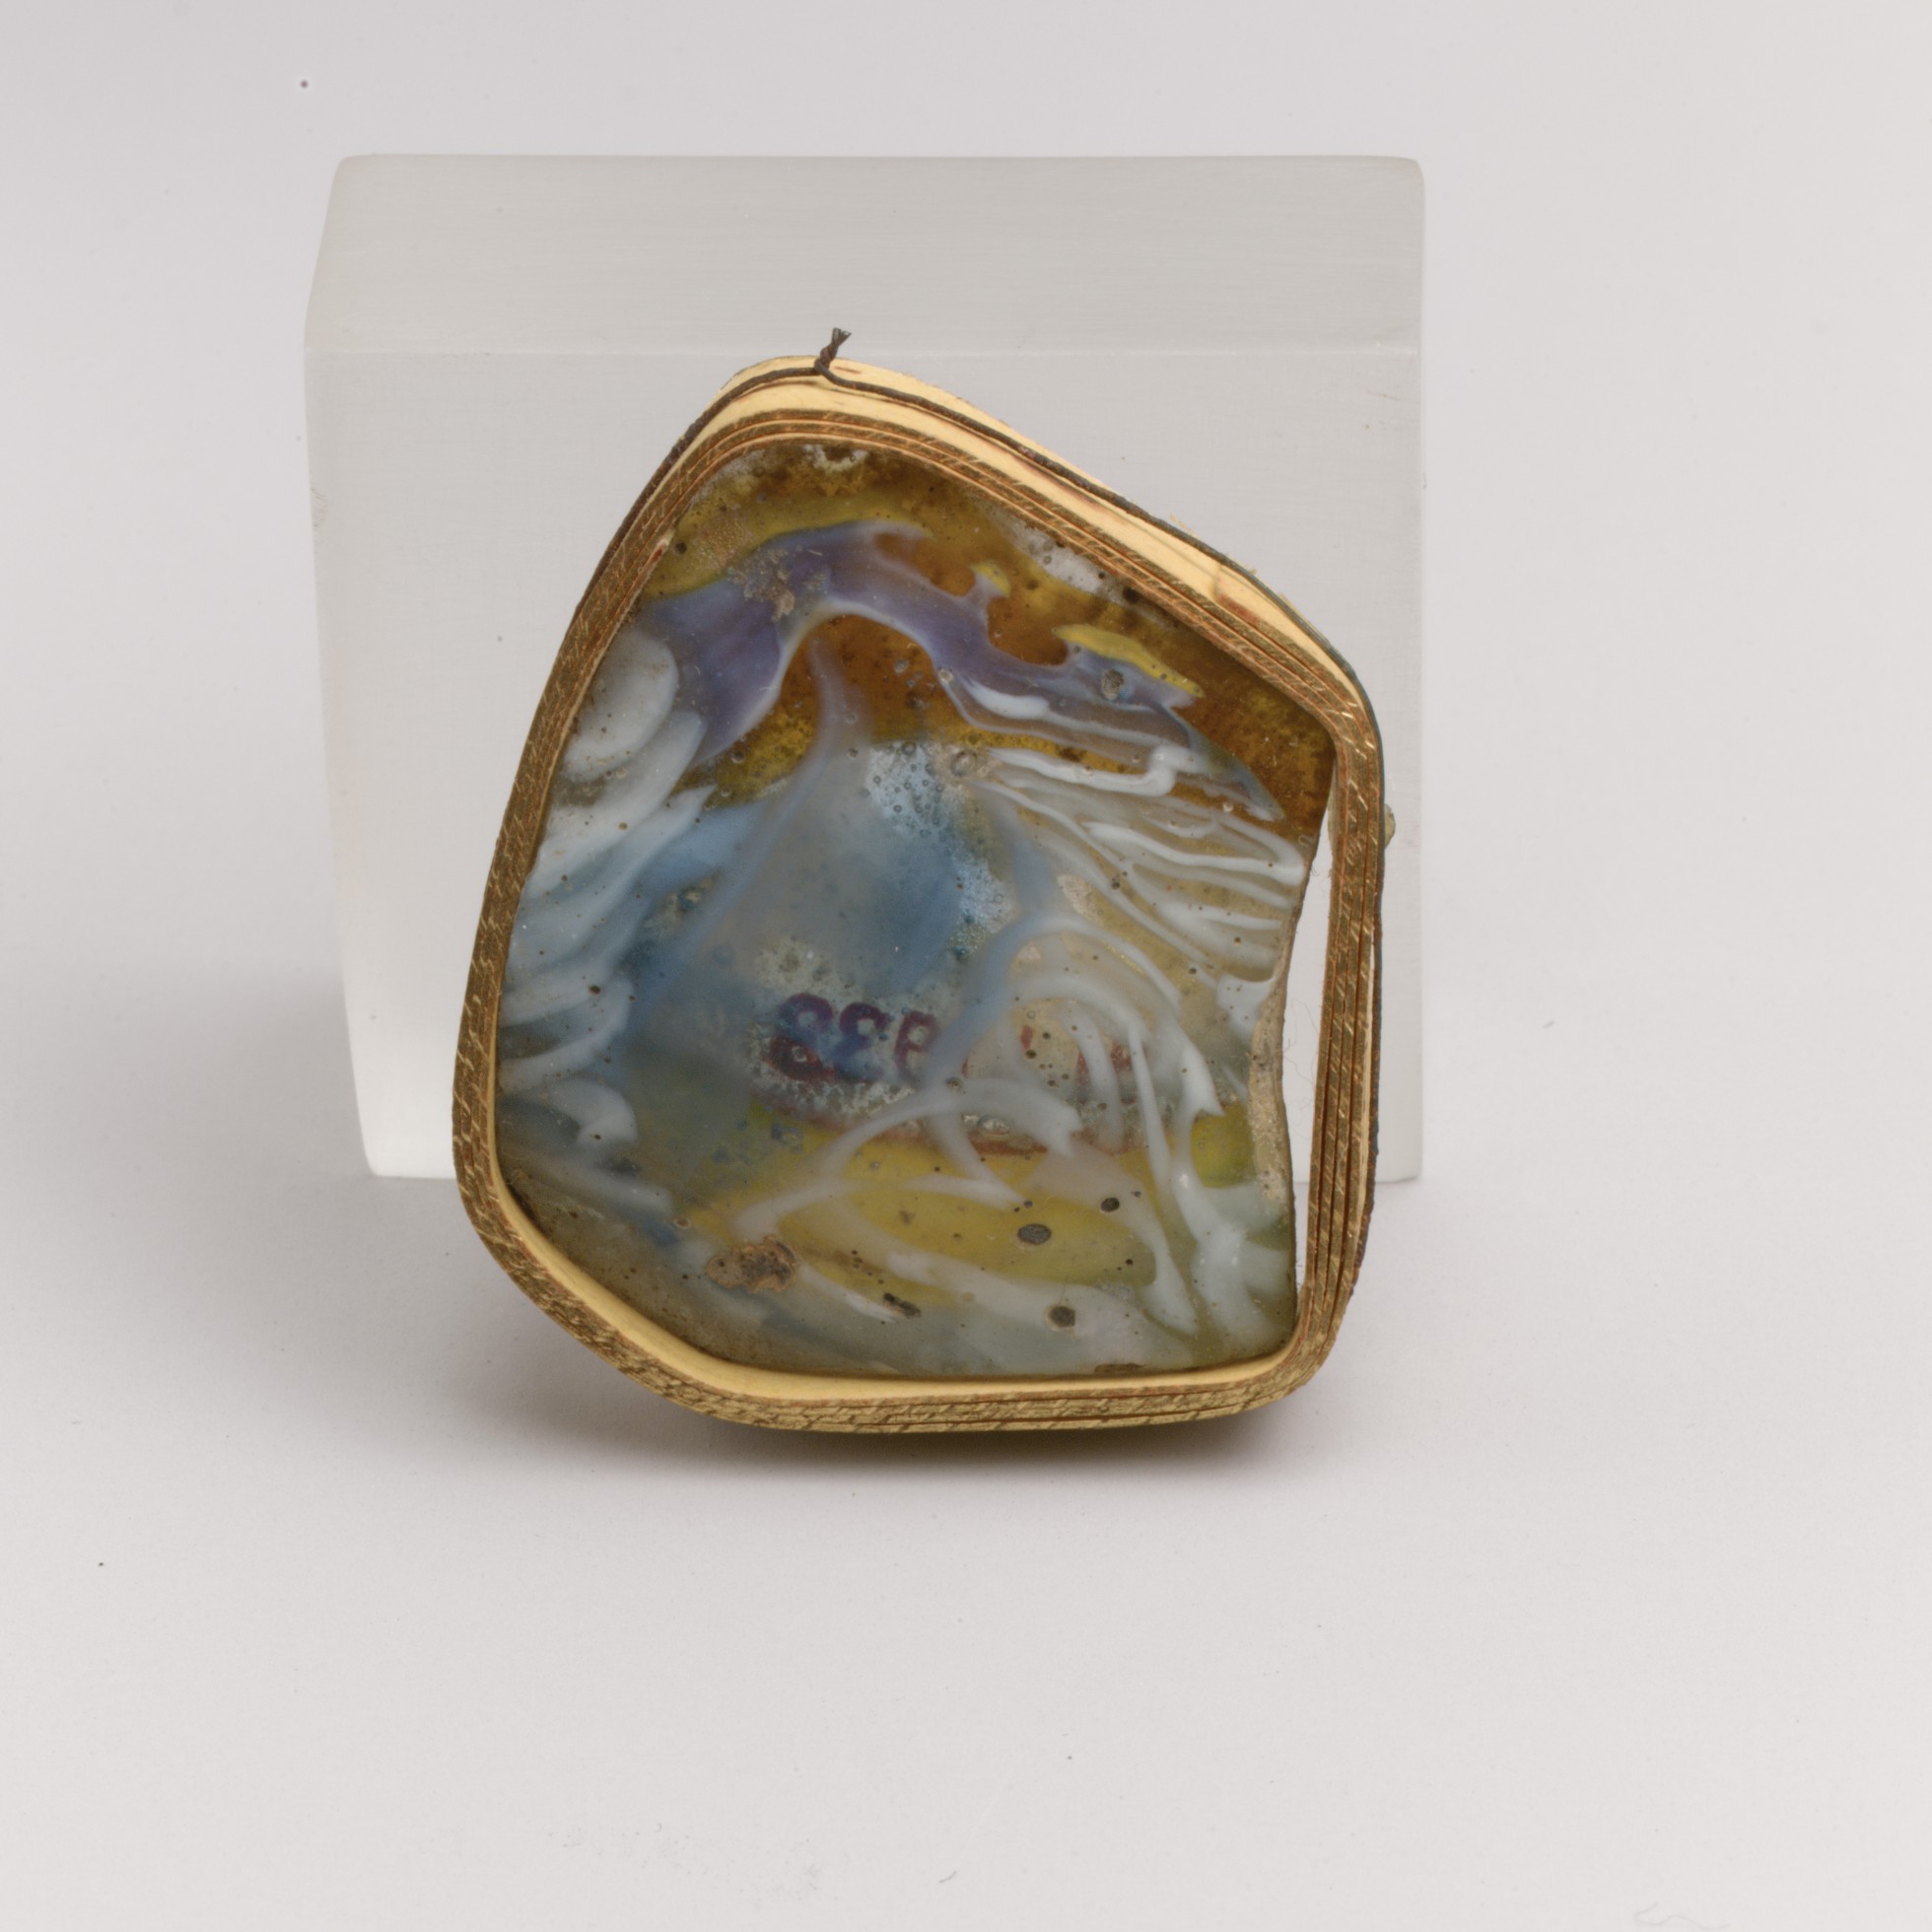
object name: fragment, mosaic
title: Glass mosaic fragment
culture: roman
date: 34 BCE-33 CE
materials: glass